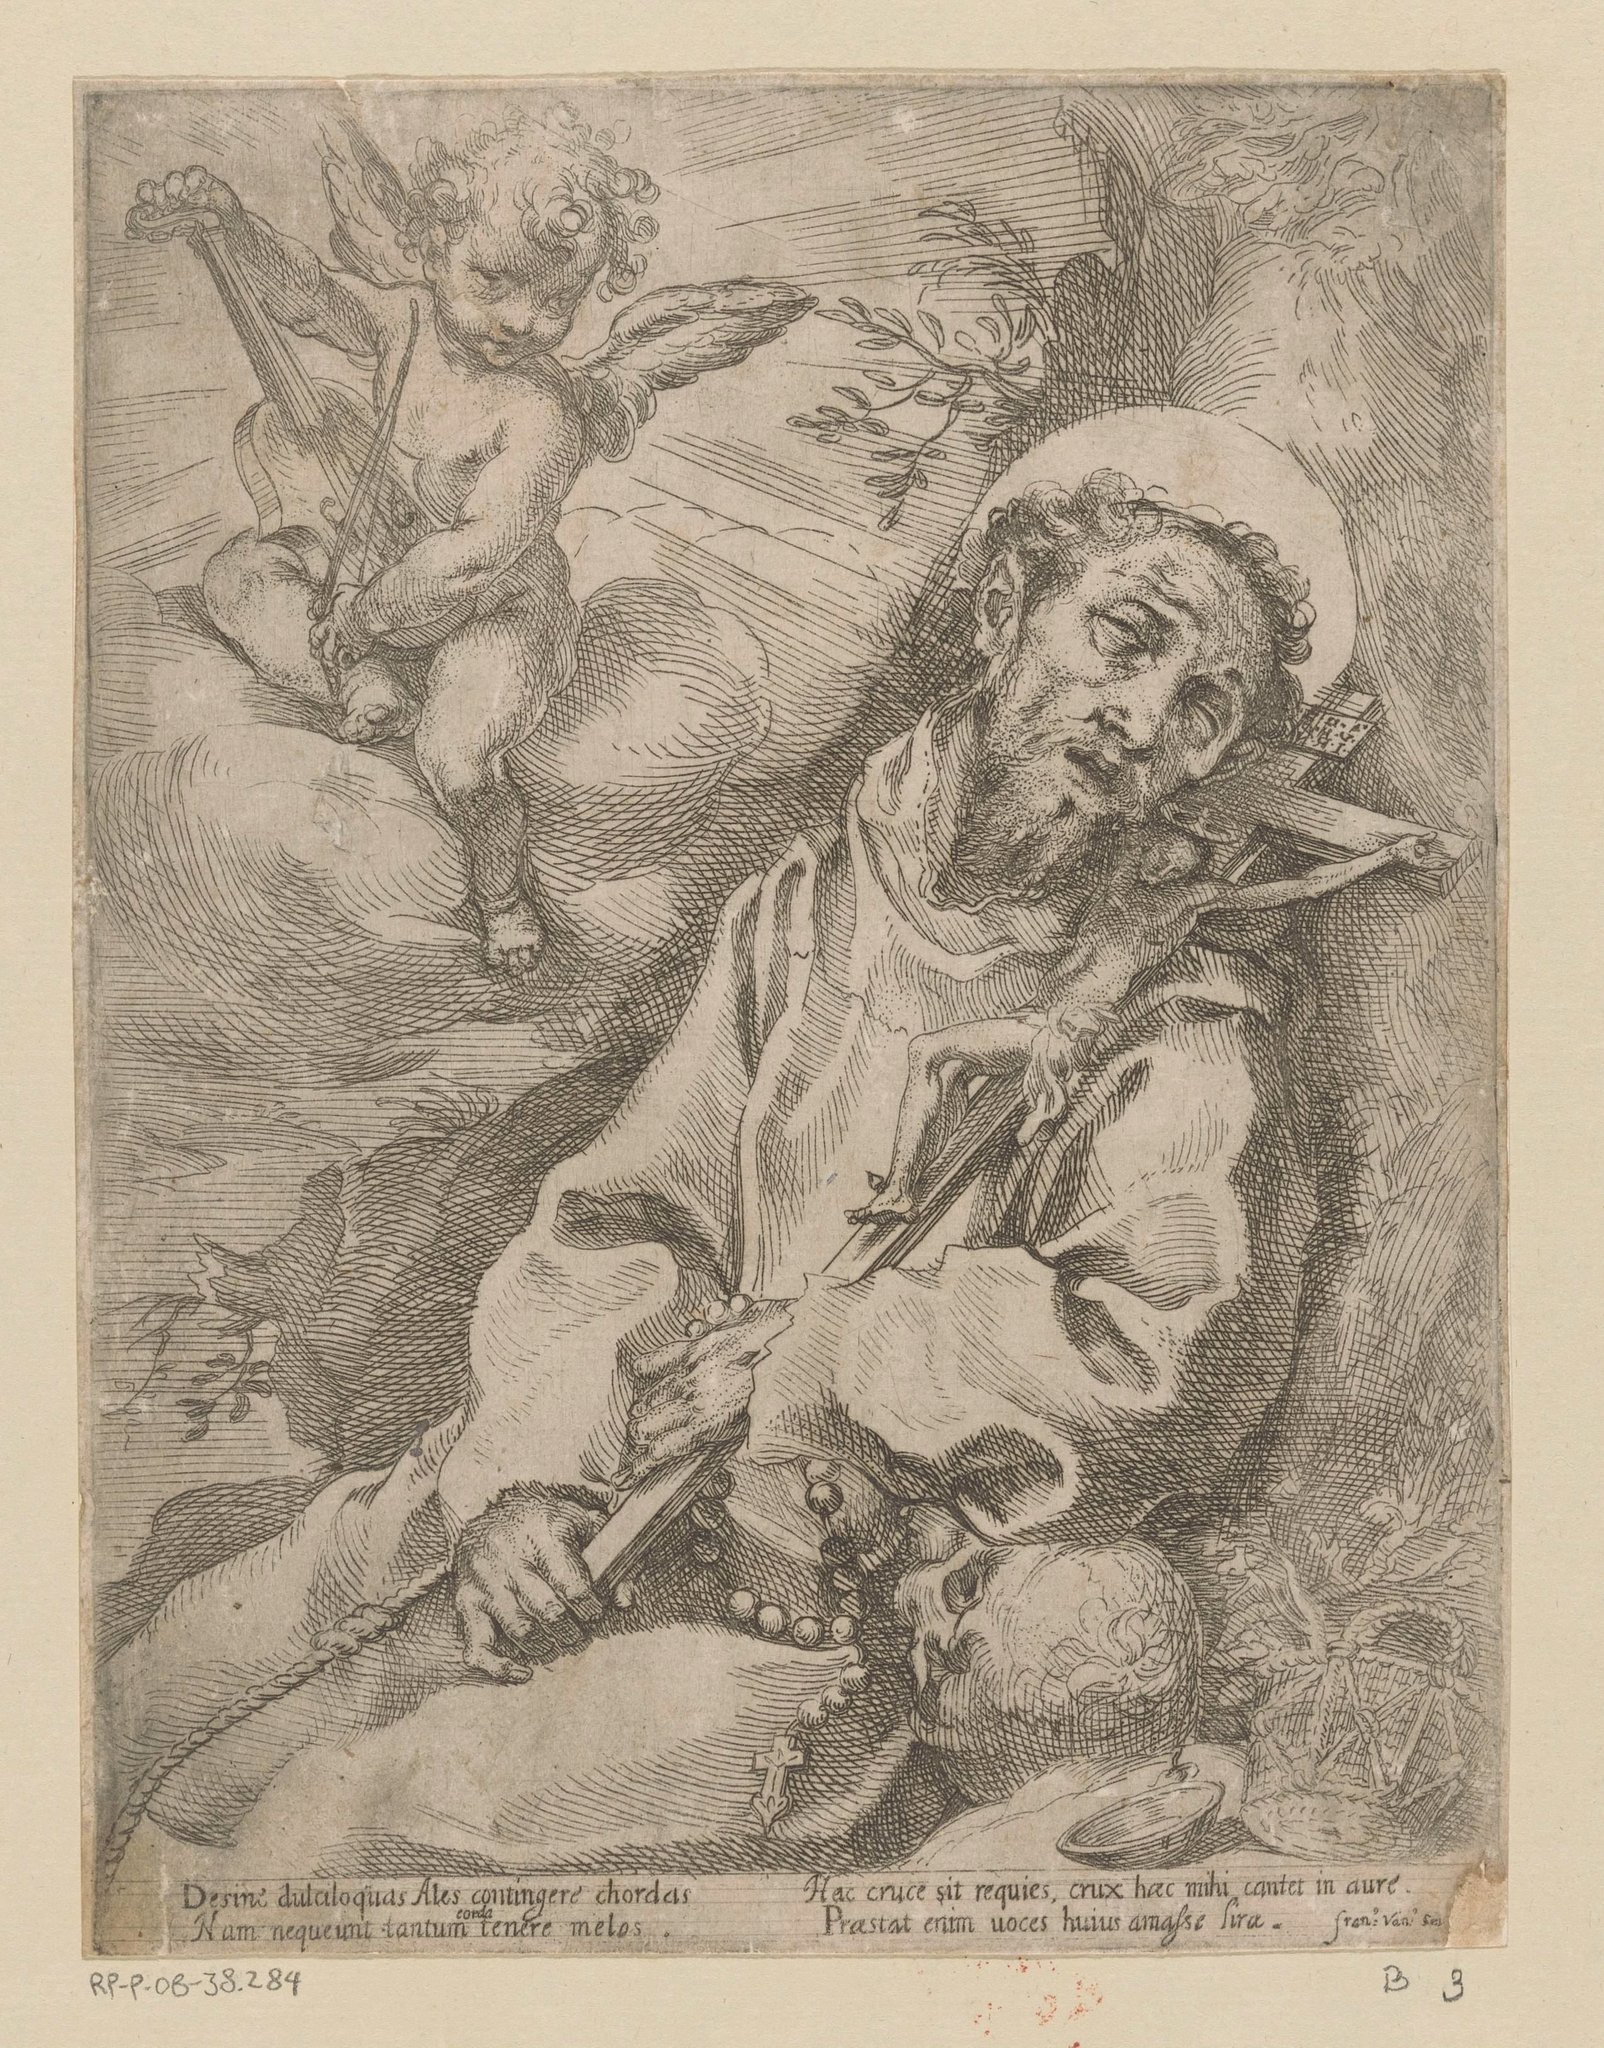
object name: print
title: Heilige Franciscus van Assisi in extase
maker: francesco vanni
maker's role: draughtsman, print maker, publisher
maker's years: 1563-1610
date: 1573-1610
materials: paper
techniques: etching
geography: italy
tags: st. francis of assisi in ecstasy, string instruments (bowed)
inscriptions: collector's mark: Lugt 240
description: De heilige Franciscus in extase met in zijn armen een crucifix en rechts een doodskop. Links op een wolkenpartij een engel met een strijkinstrument. Latijnse tekst in twee kolommen in ondermarge.